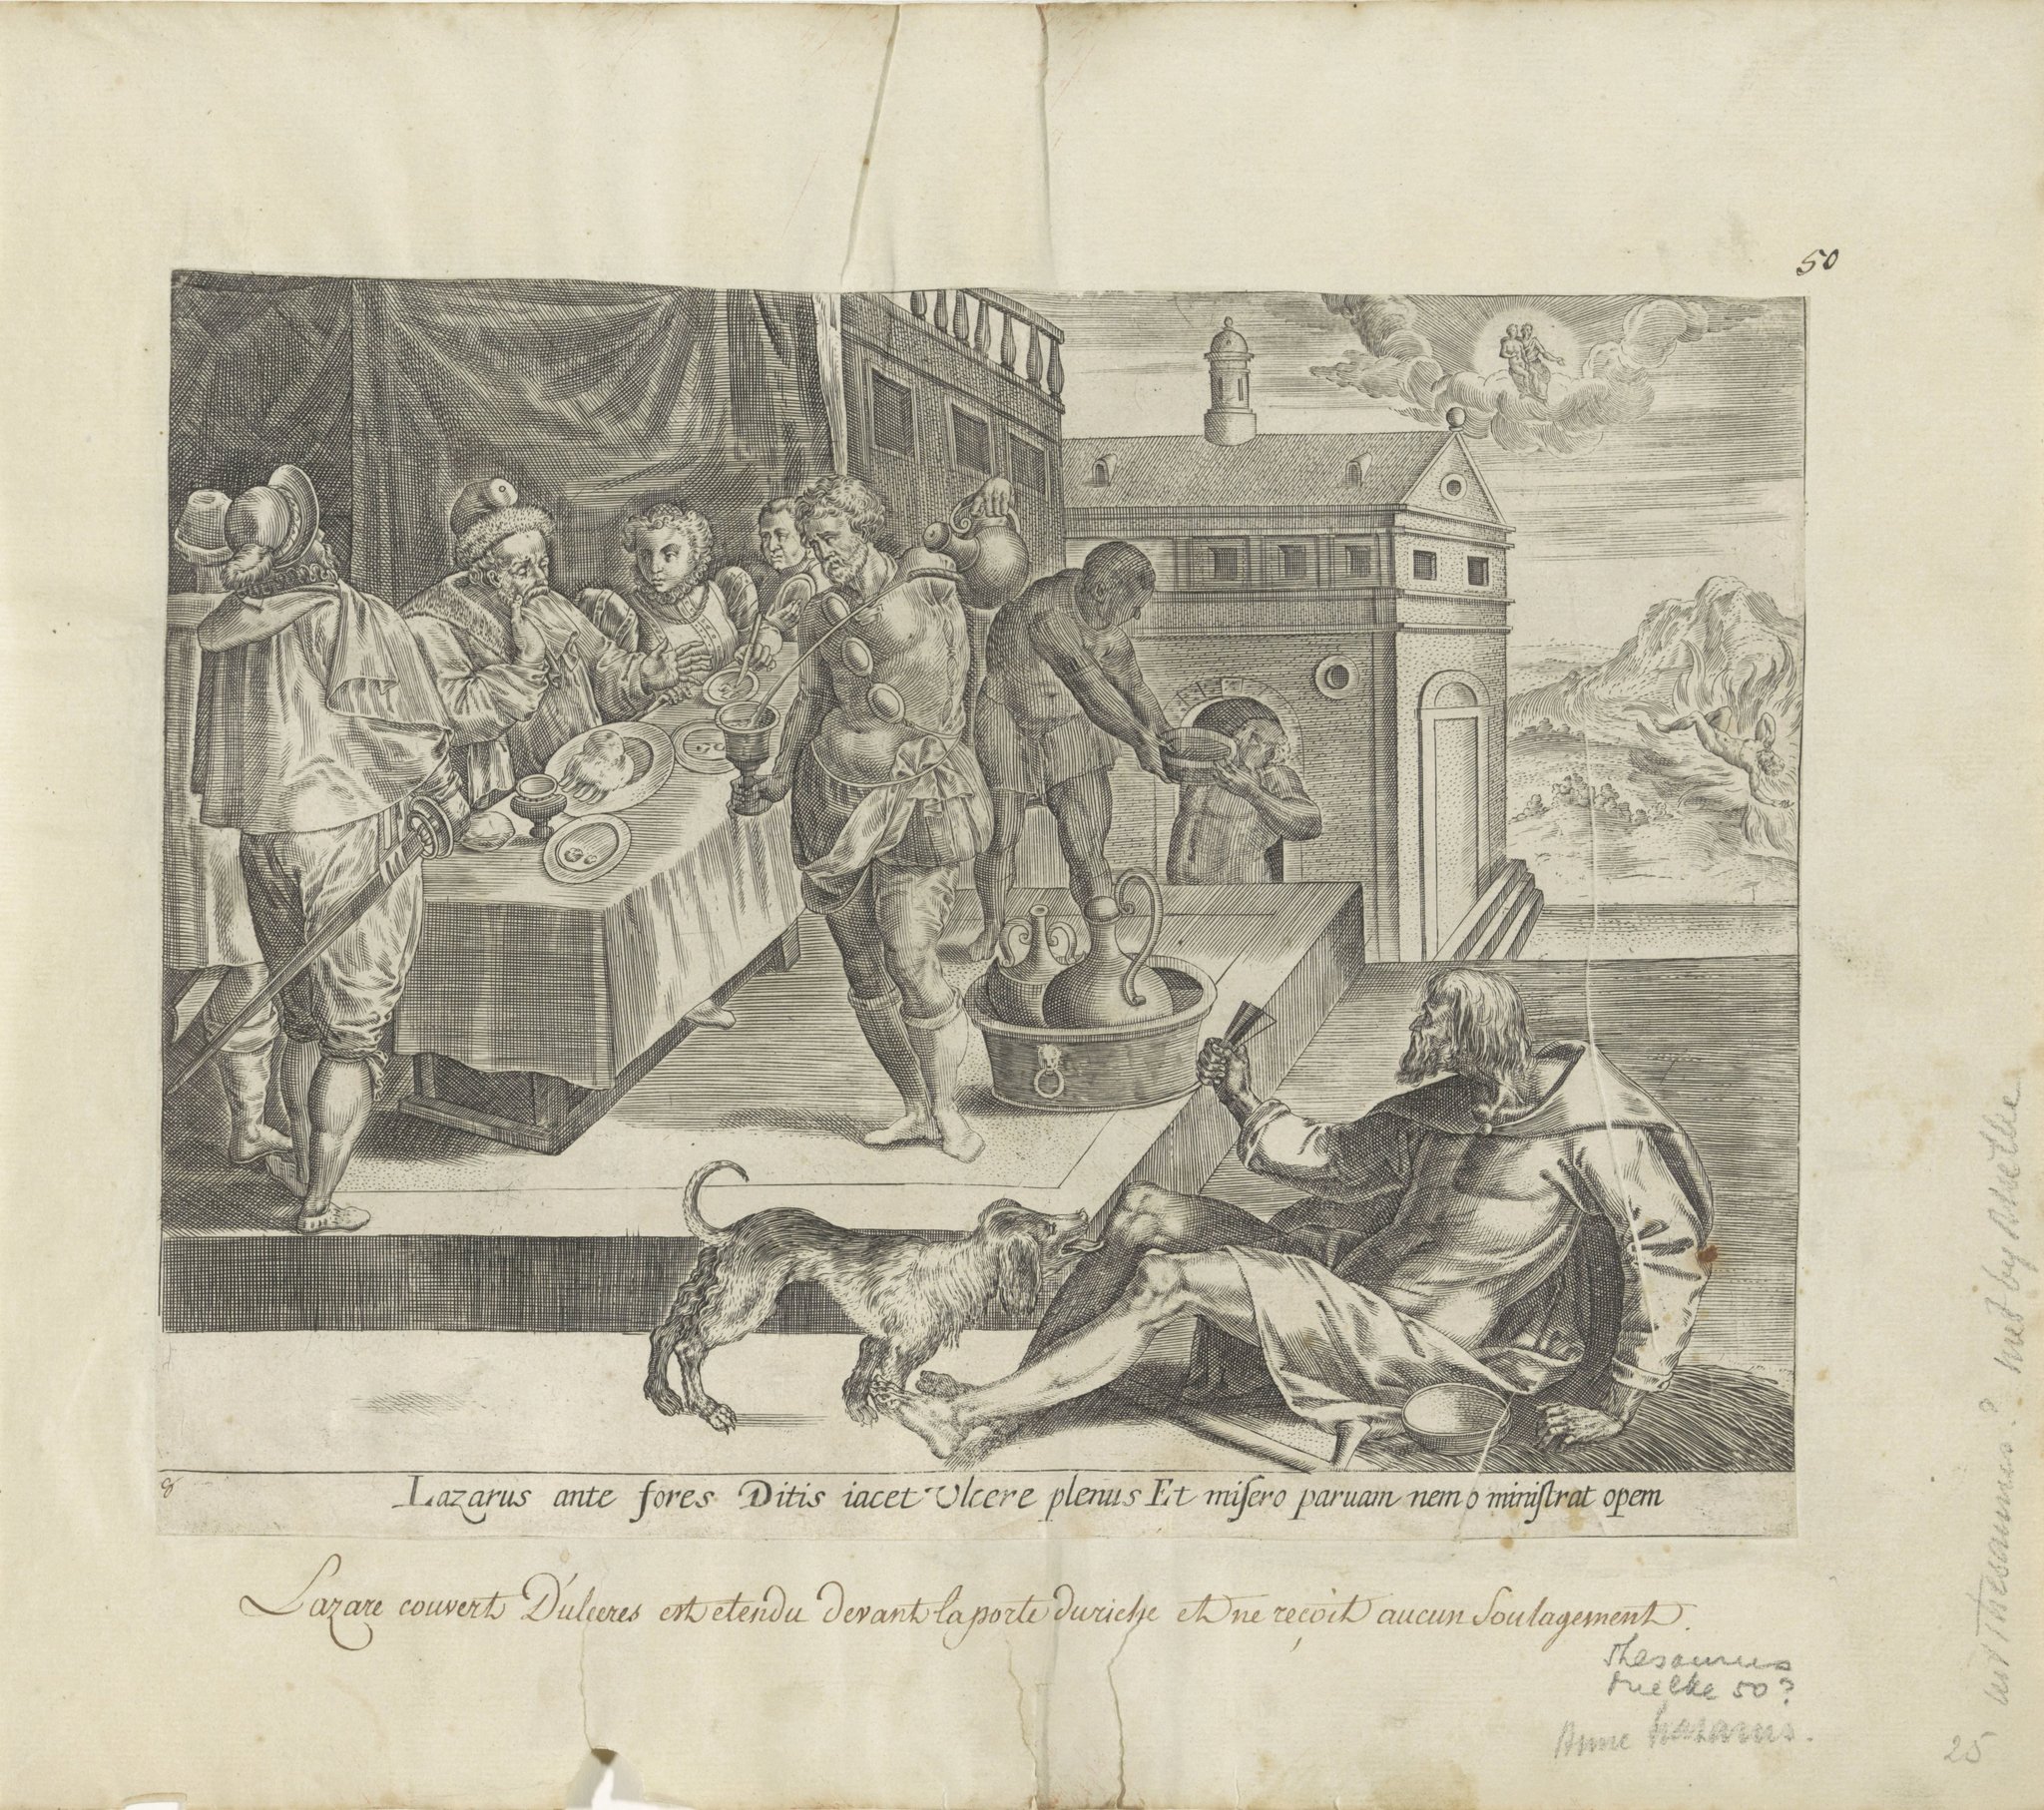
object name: print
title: Gelijkenis van de rijke man en de arme Lazarus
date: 1585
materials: paper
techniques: engraving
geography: antwerp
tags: the rich man (dives) is feasting, while poor lazarus is starving at the gate (dogs licking lazarus' sores) (luke 16:19-31)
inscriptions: collector's mark: Lugt 2228, number: ‘50’, inscription: ‘Lazare couvert Duleeres est etendu devant la porte durietse et ne recoit aucun soulagement.’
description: Een rijke man zit met zijn familie en gasten aan tafel. Rechts buiten het huis bedelt de bedelaar Lazarus, wiens zweren door een hond worden gelikt. Op de achtergrond wordt het vervolg van het verhaal verbeeld. Als de rijke man en Lazarus zijn gestorven, zit Lazarus in de hemel bij Abraham op schoot. De rijke man bevindt zich in de vlammen van de hel. Onder de voorstelling een verwijzing in het Latijn naar de Bijbeltekst.